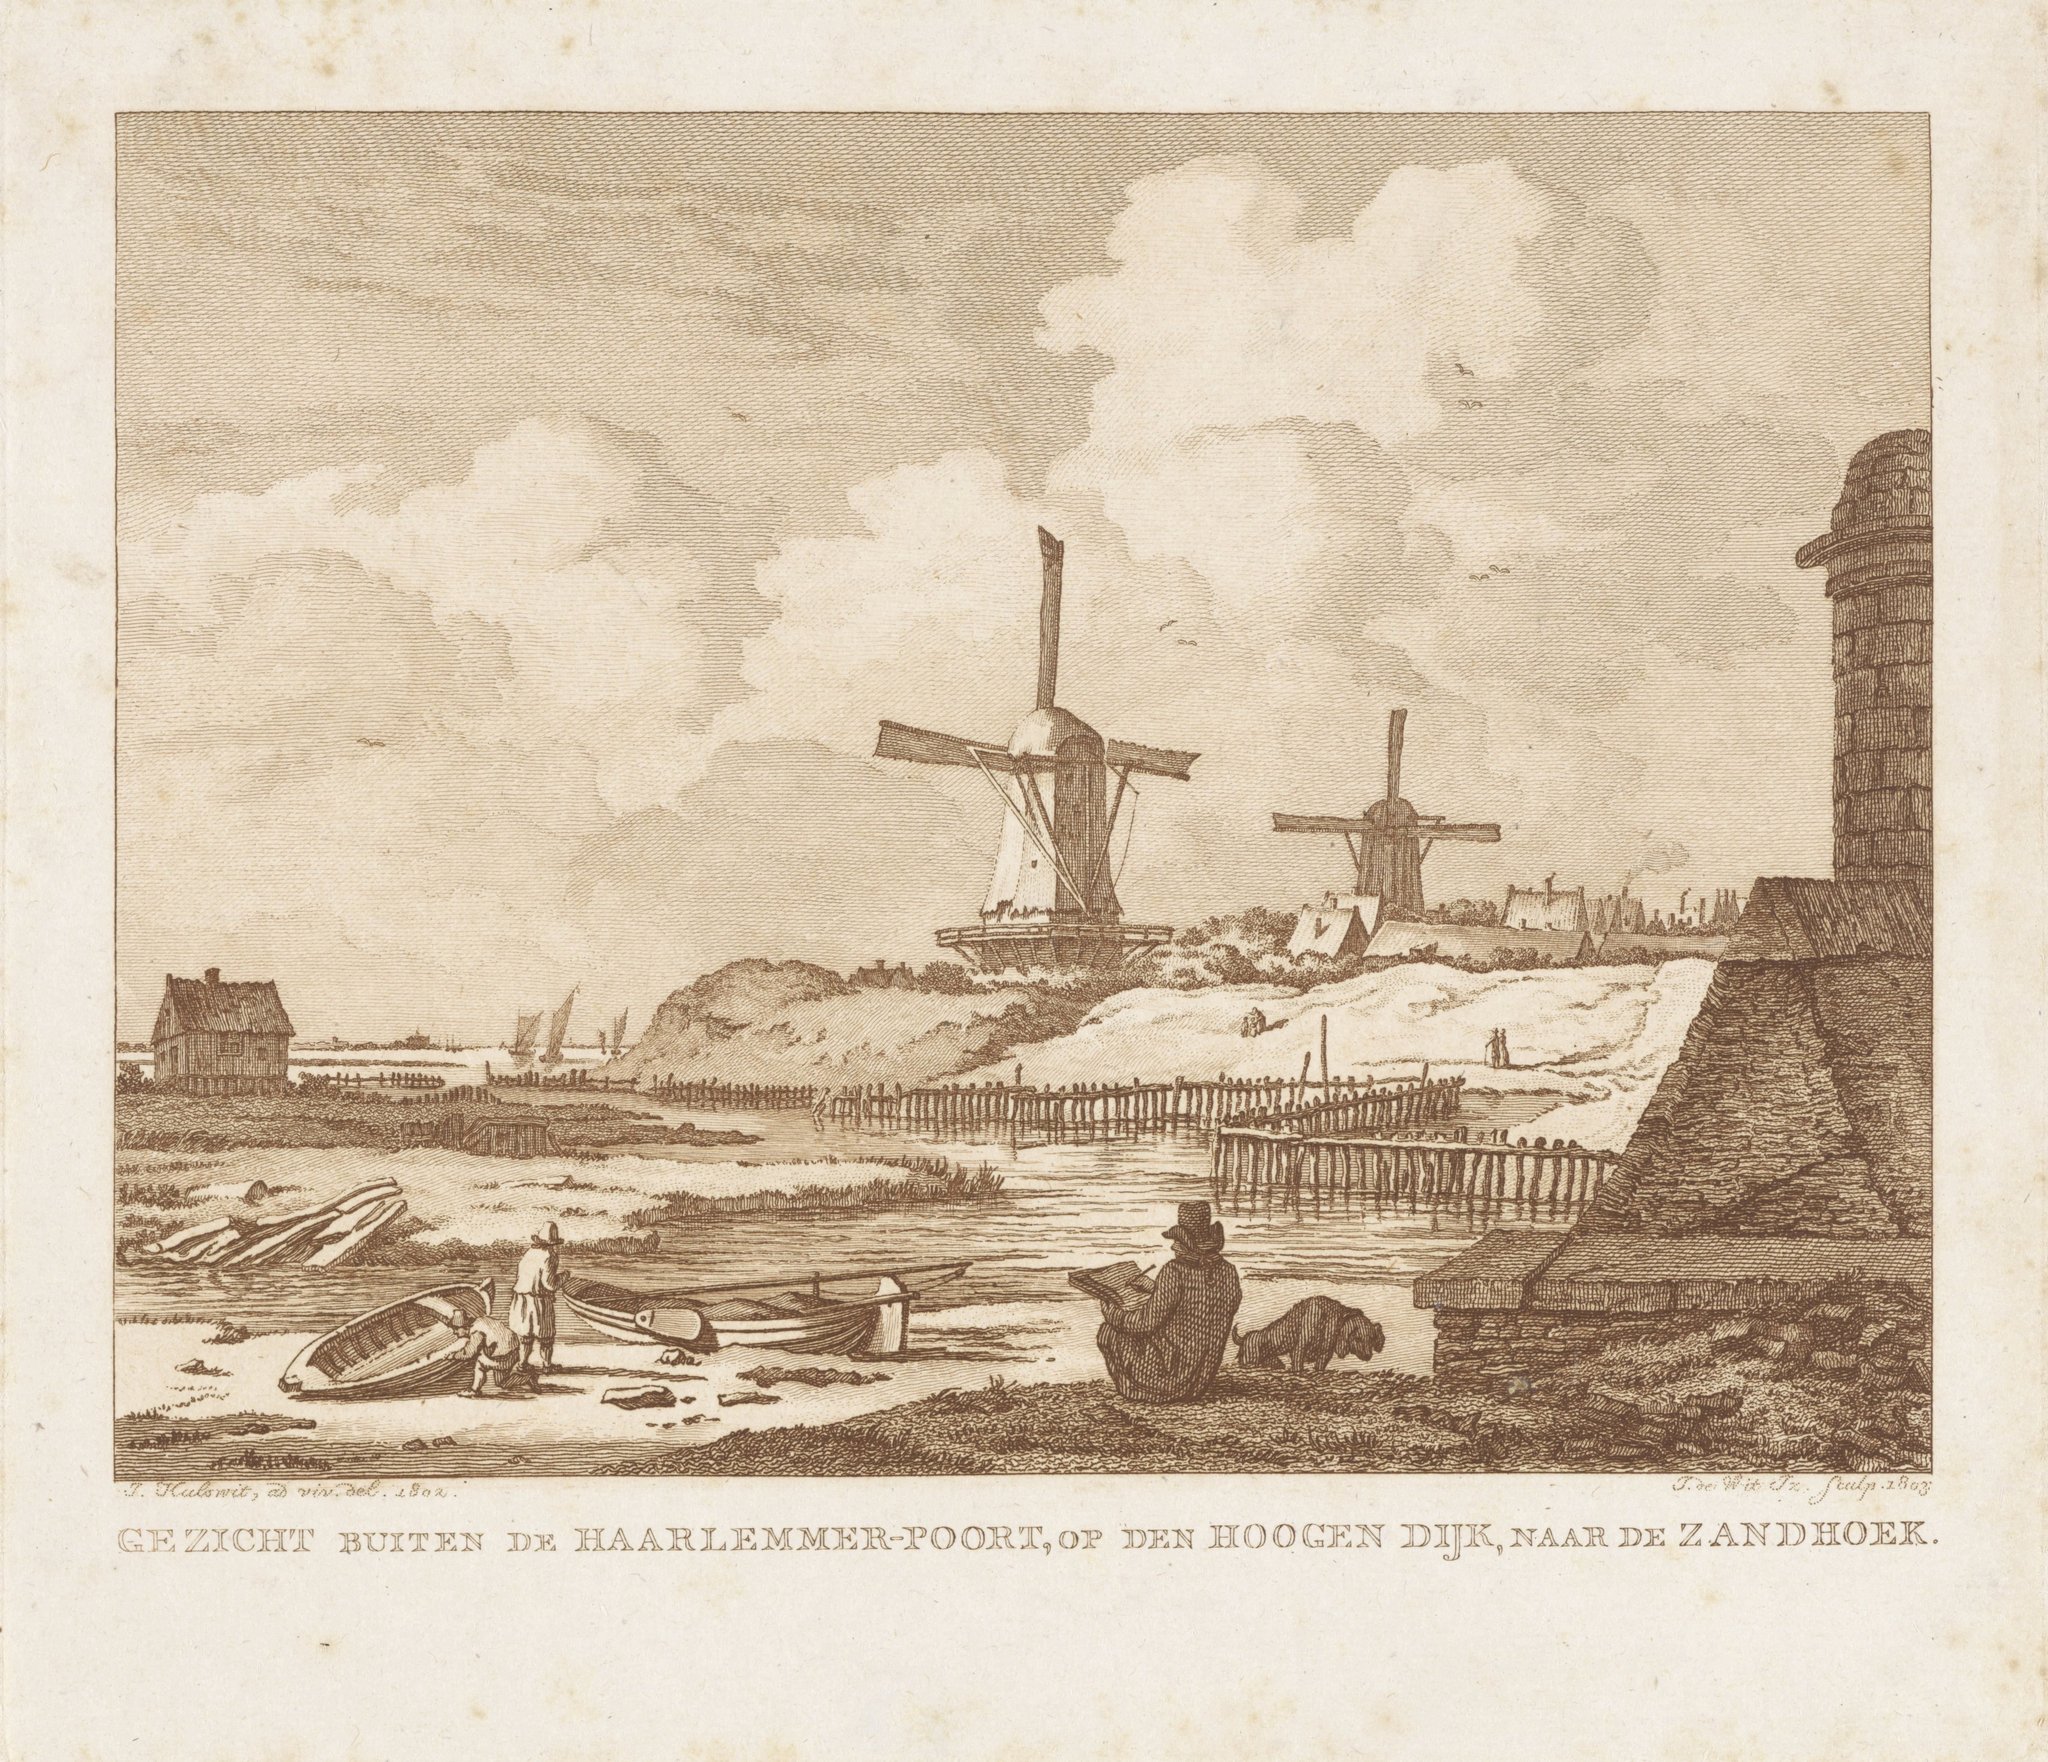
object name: print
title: Gezicht buiten de Haarlemmerpoort te Amsterdam met een zittende tekenaar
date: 1803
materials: paper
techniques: etching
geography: haarlem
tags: artist (in general) making preliminary designs, sketching - bb - out of doors (+ artist at work), windmill in landscape, repairing, caulking, careening (~ ship)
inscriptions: date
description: Een tekenaar met een hond zit bij een dijk met molens en huizen, buiten de Haarlemmerpoort te Amsterdam. Voor hem twee mannen die hun boten repareren.